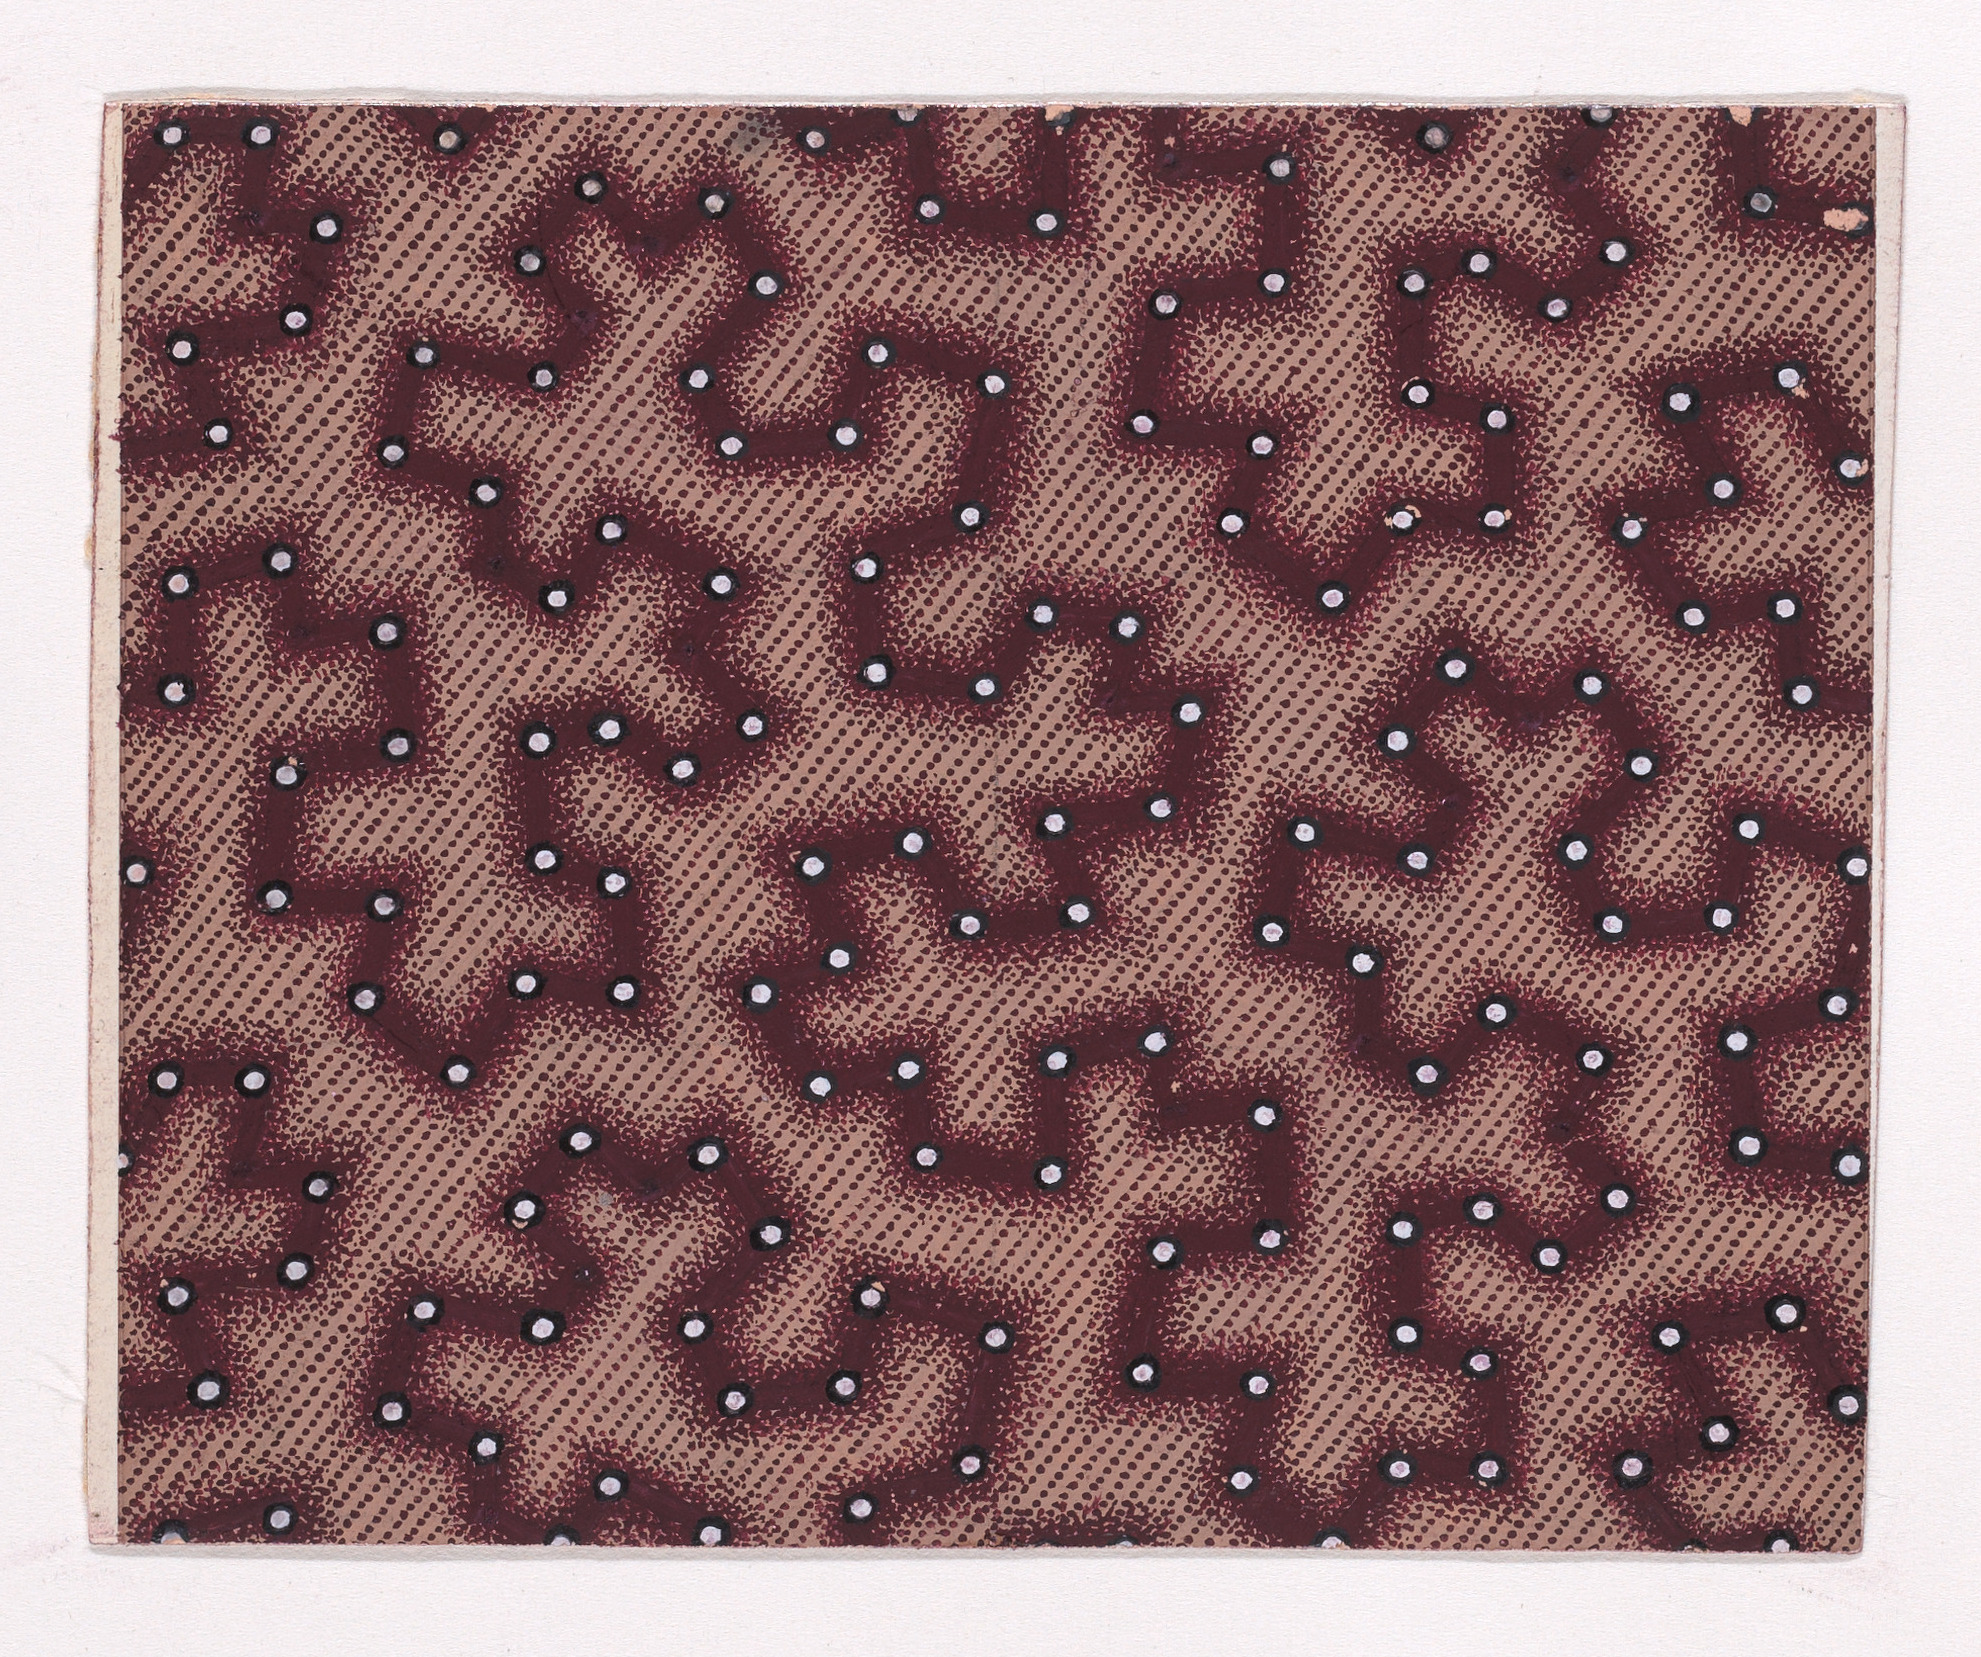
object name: drawing ornament architecture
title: Textile Design with a Vermicular Pattern Decorated with Pearls over a Background of Diagonal Stripes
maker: anonymous, alsatian, 19th century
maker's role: artist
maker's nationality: alsatian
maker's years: 1800-1900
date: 1840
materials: gouache